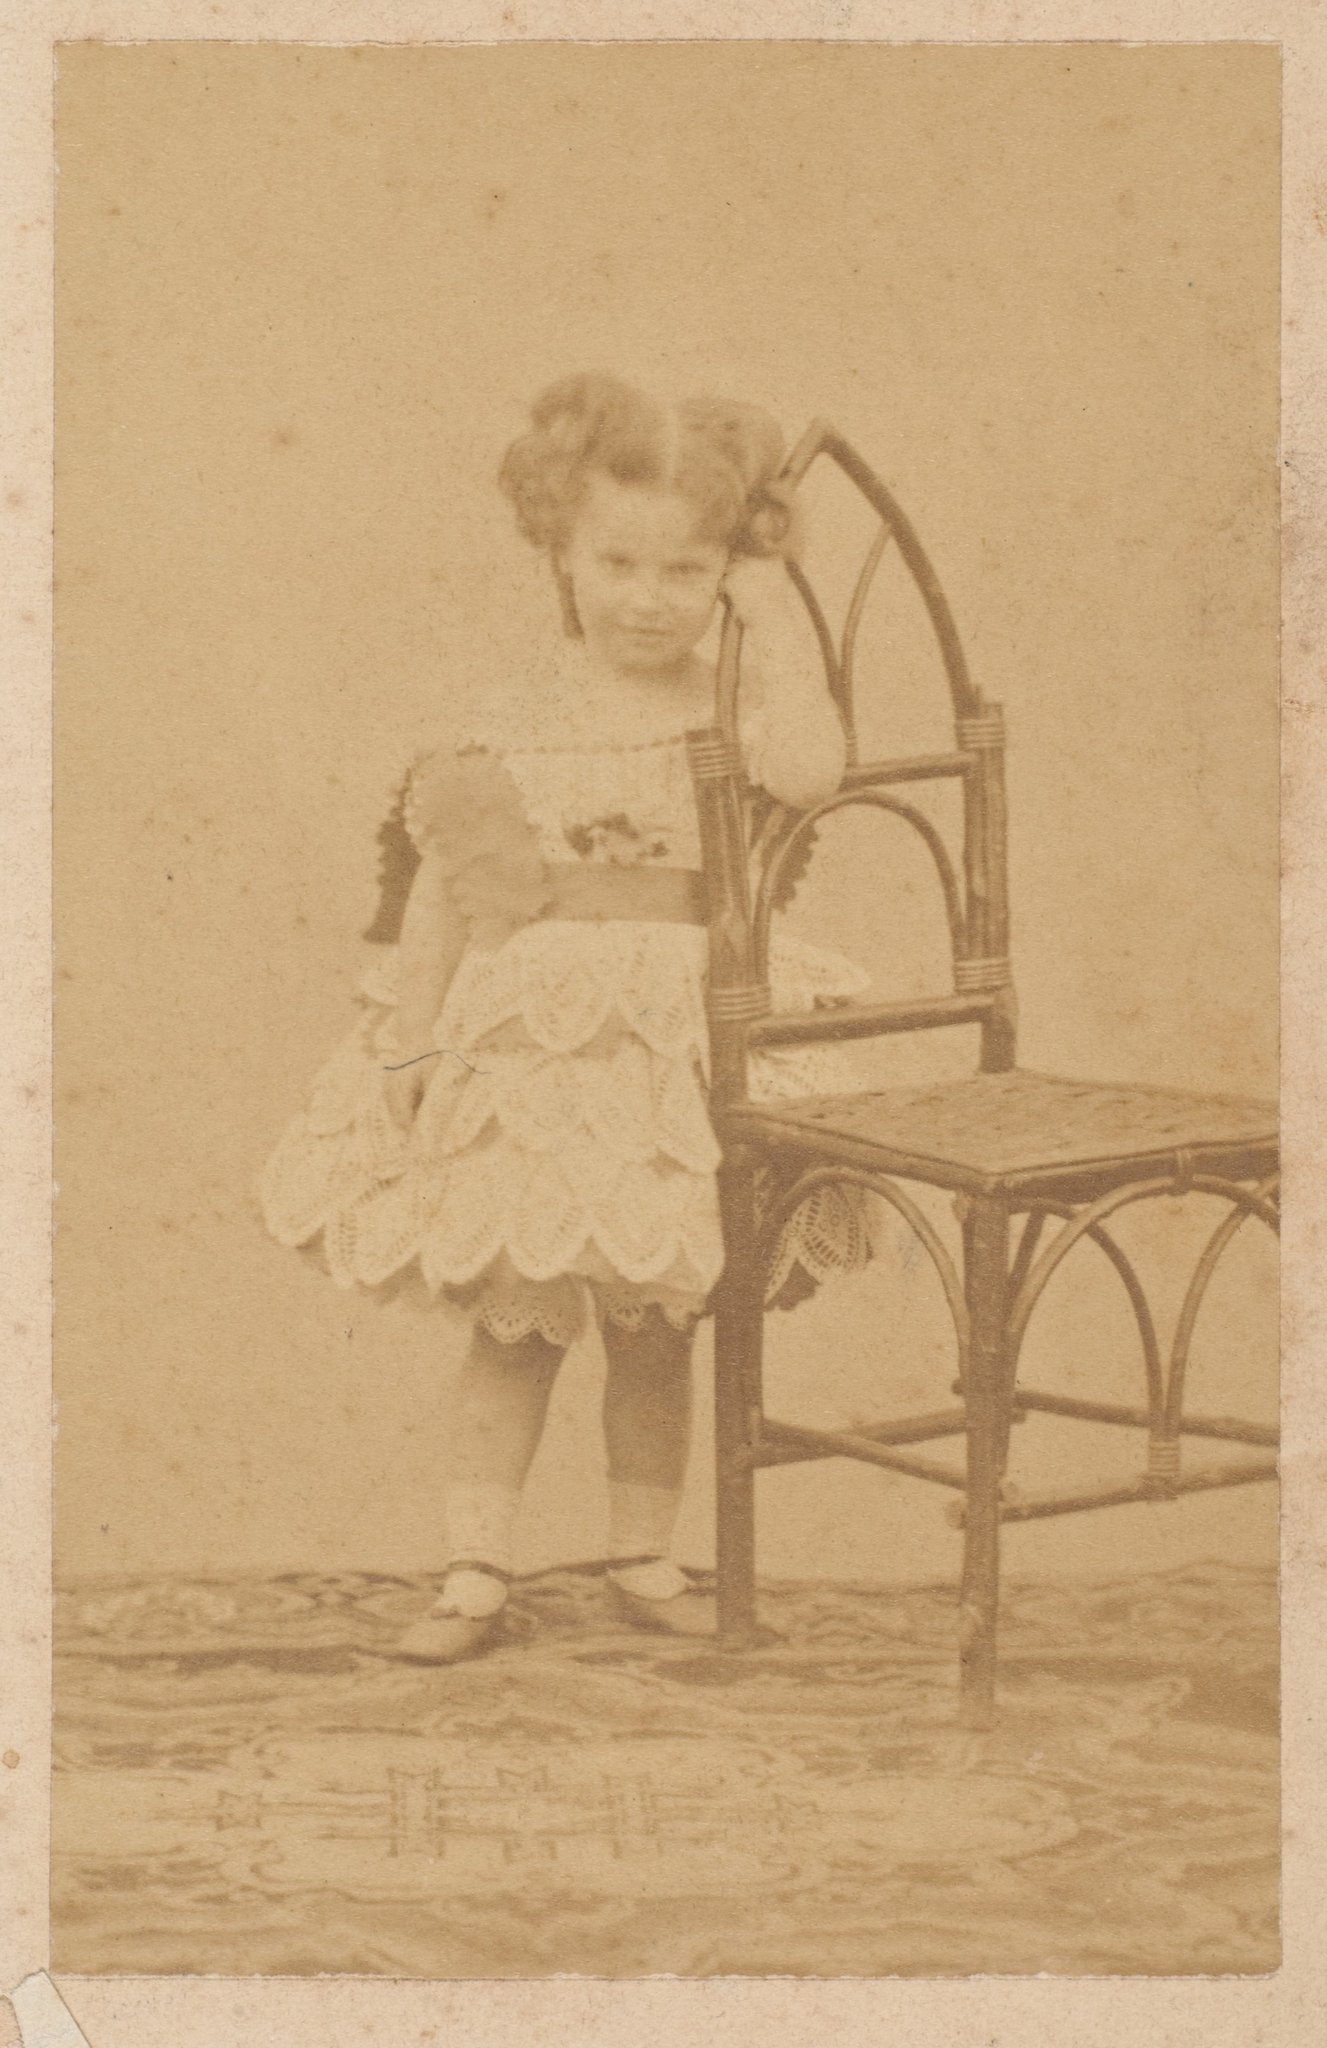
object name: photograph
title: Chaise rustique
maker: pierre-louis pierson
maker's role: artist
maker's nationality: french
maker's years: 1822-1913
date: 1860-1869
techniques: albumen silver print, glass negative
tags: girls,portraits